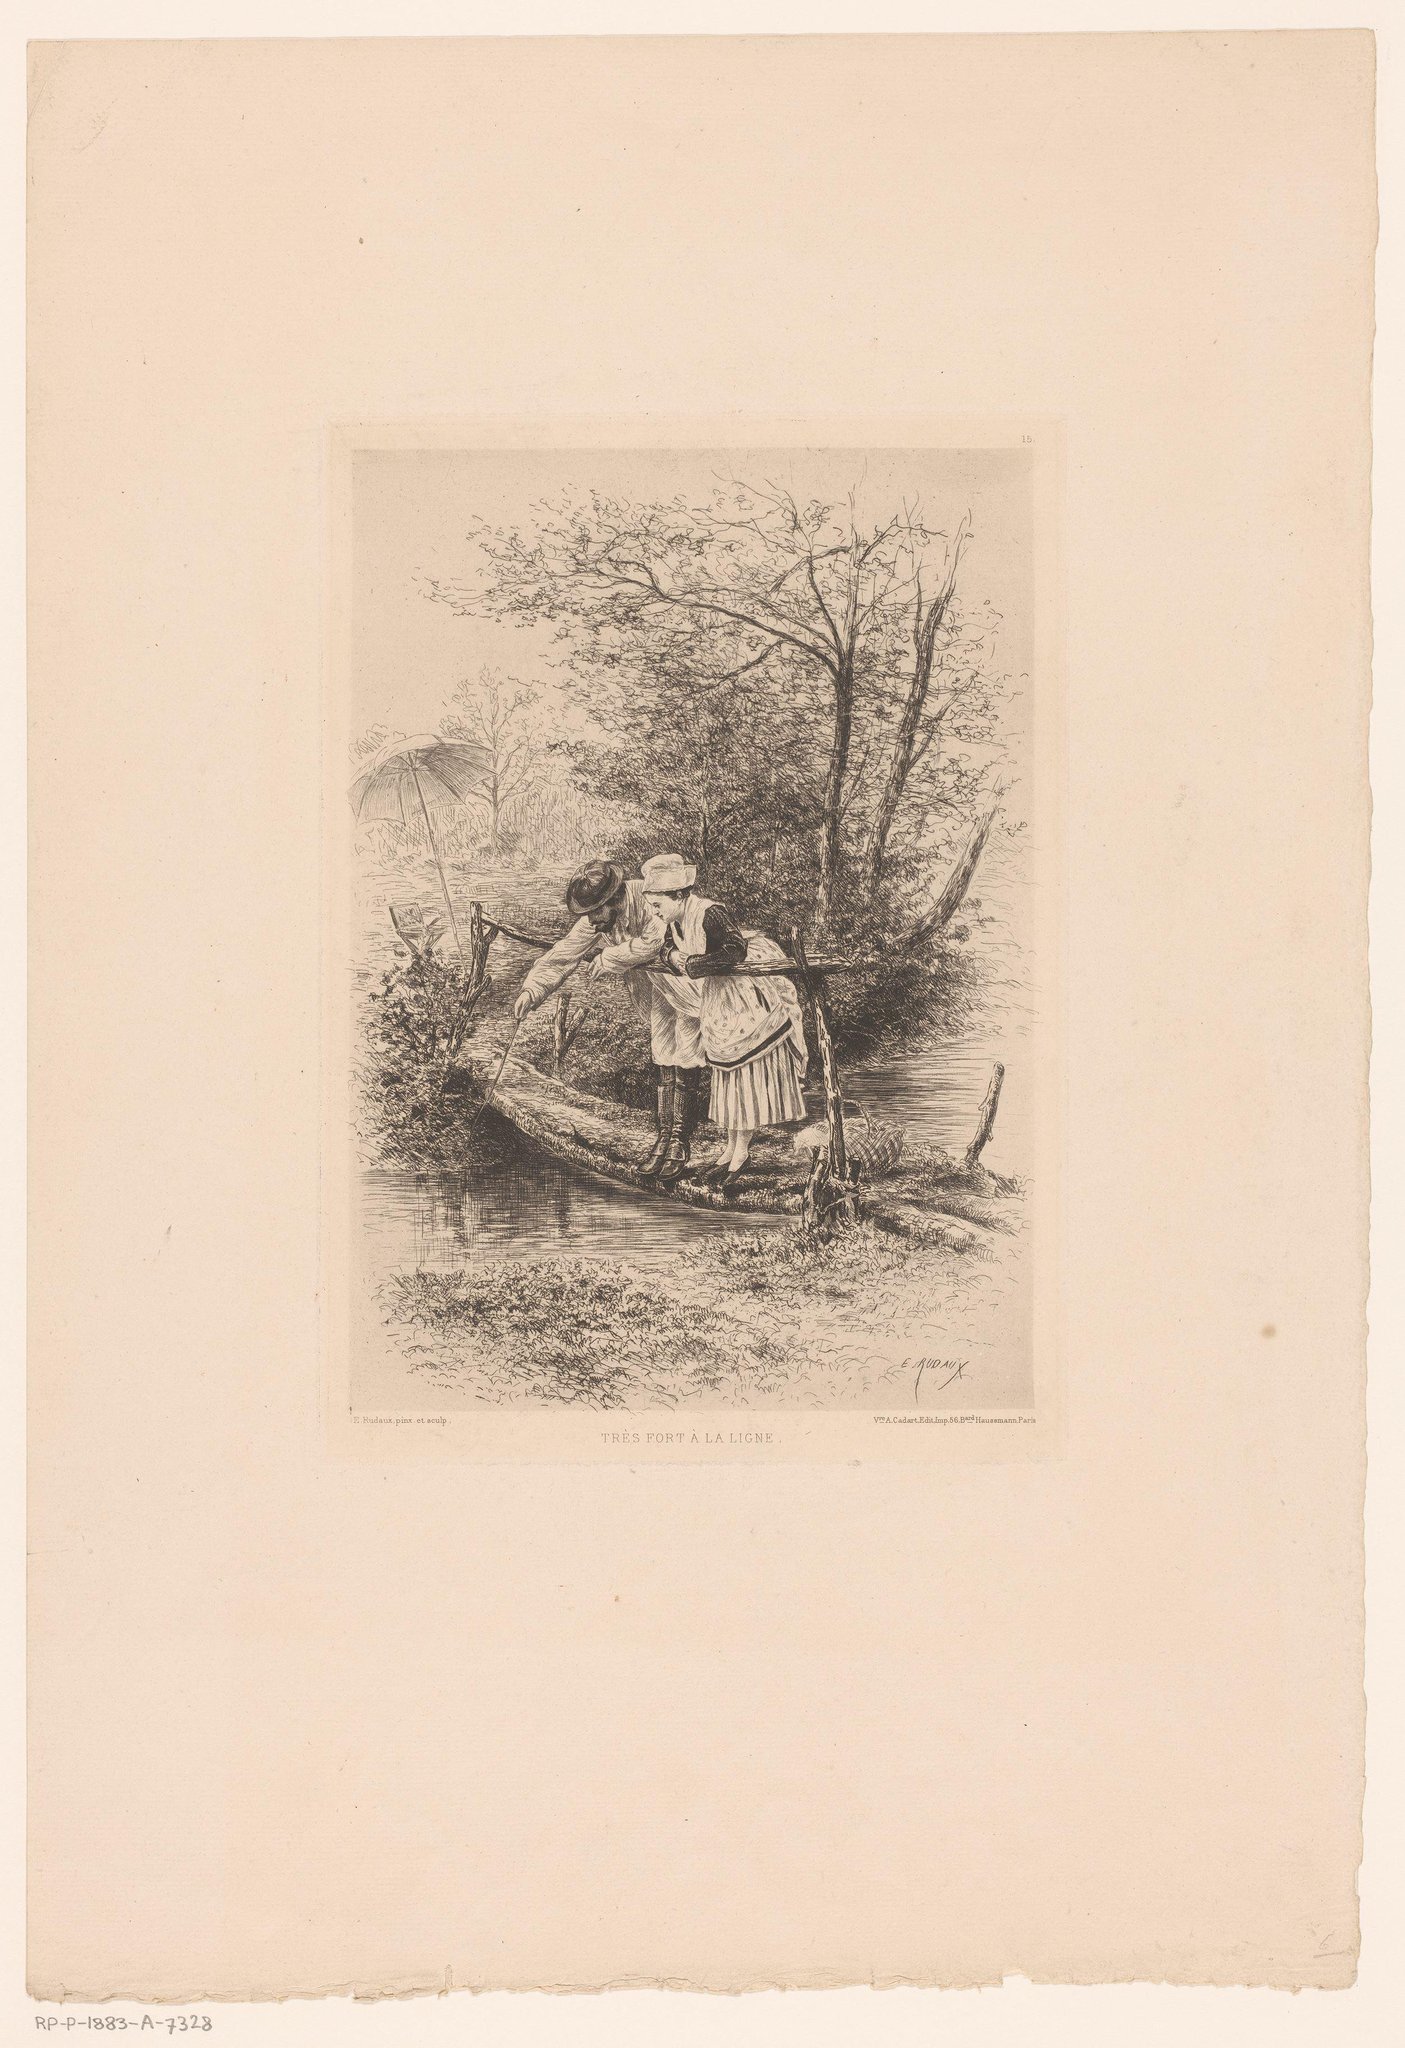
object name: print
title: Boslandschap met hengelend paar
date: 1878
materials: paper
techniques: drypoint, etching, intaglio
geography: paris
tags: forest, wood, angling, couple of lovers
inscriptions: collector's mark: Lugt 2228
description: Prent uit: L'Eau Forte en 1878. Parijs: Alfred Cadard, 1878. Plaat 15.